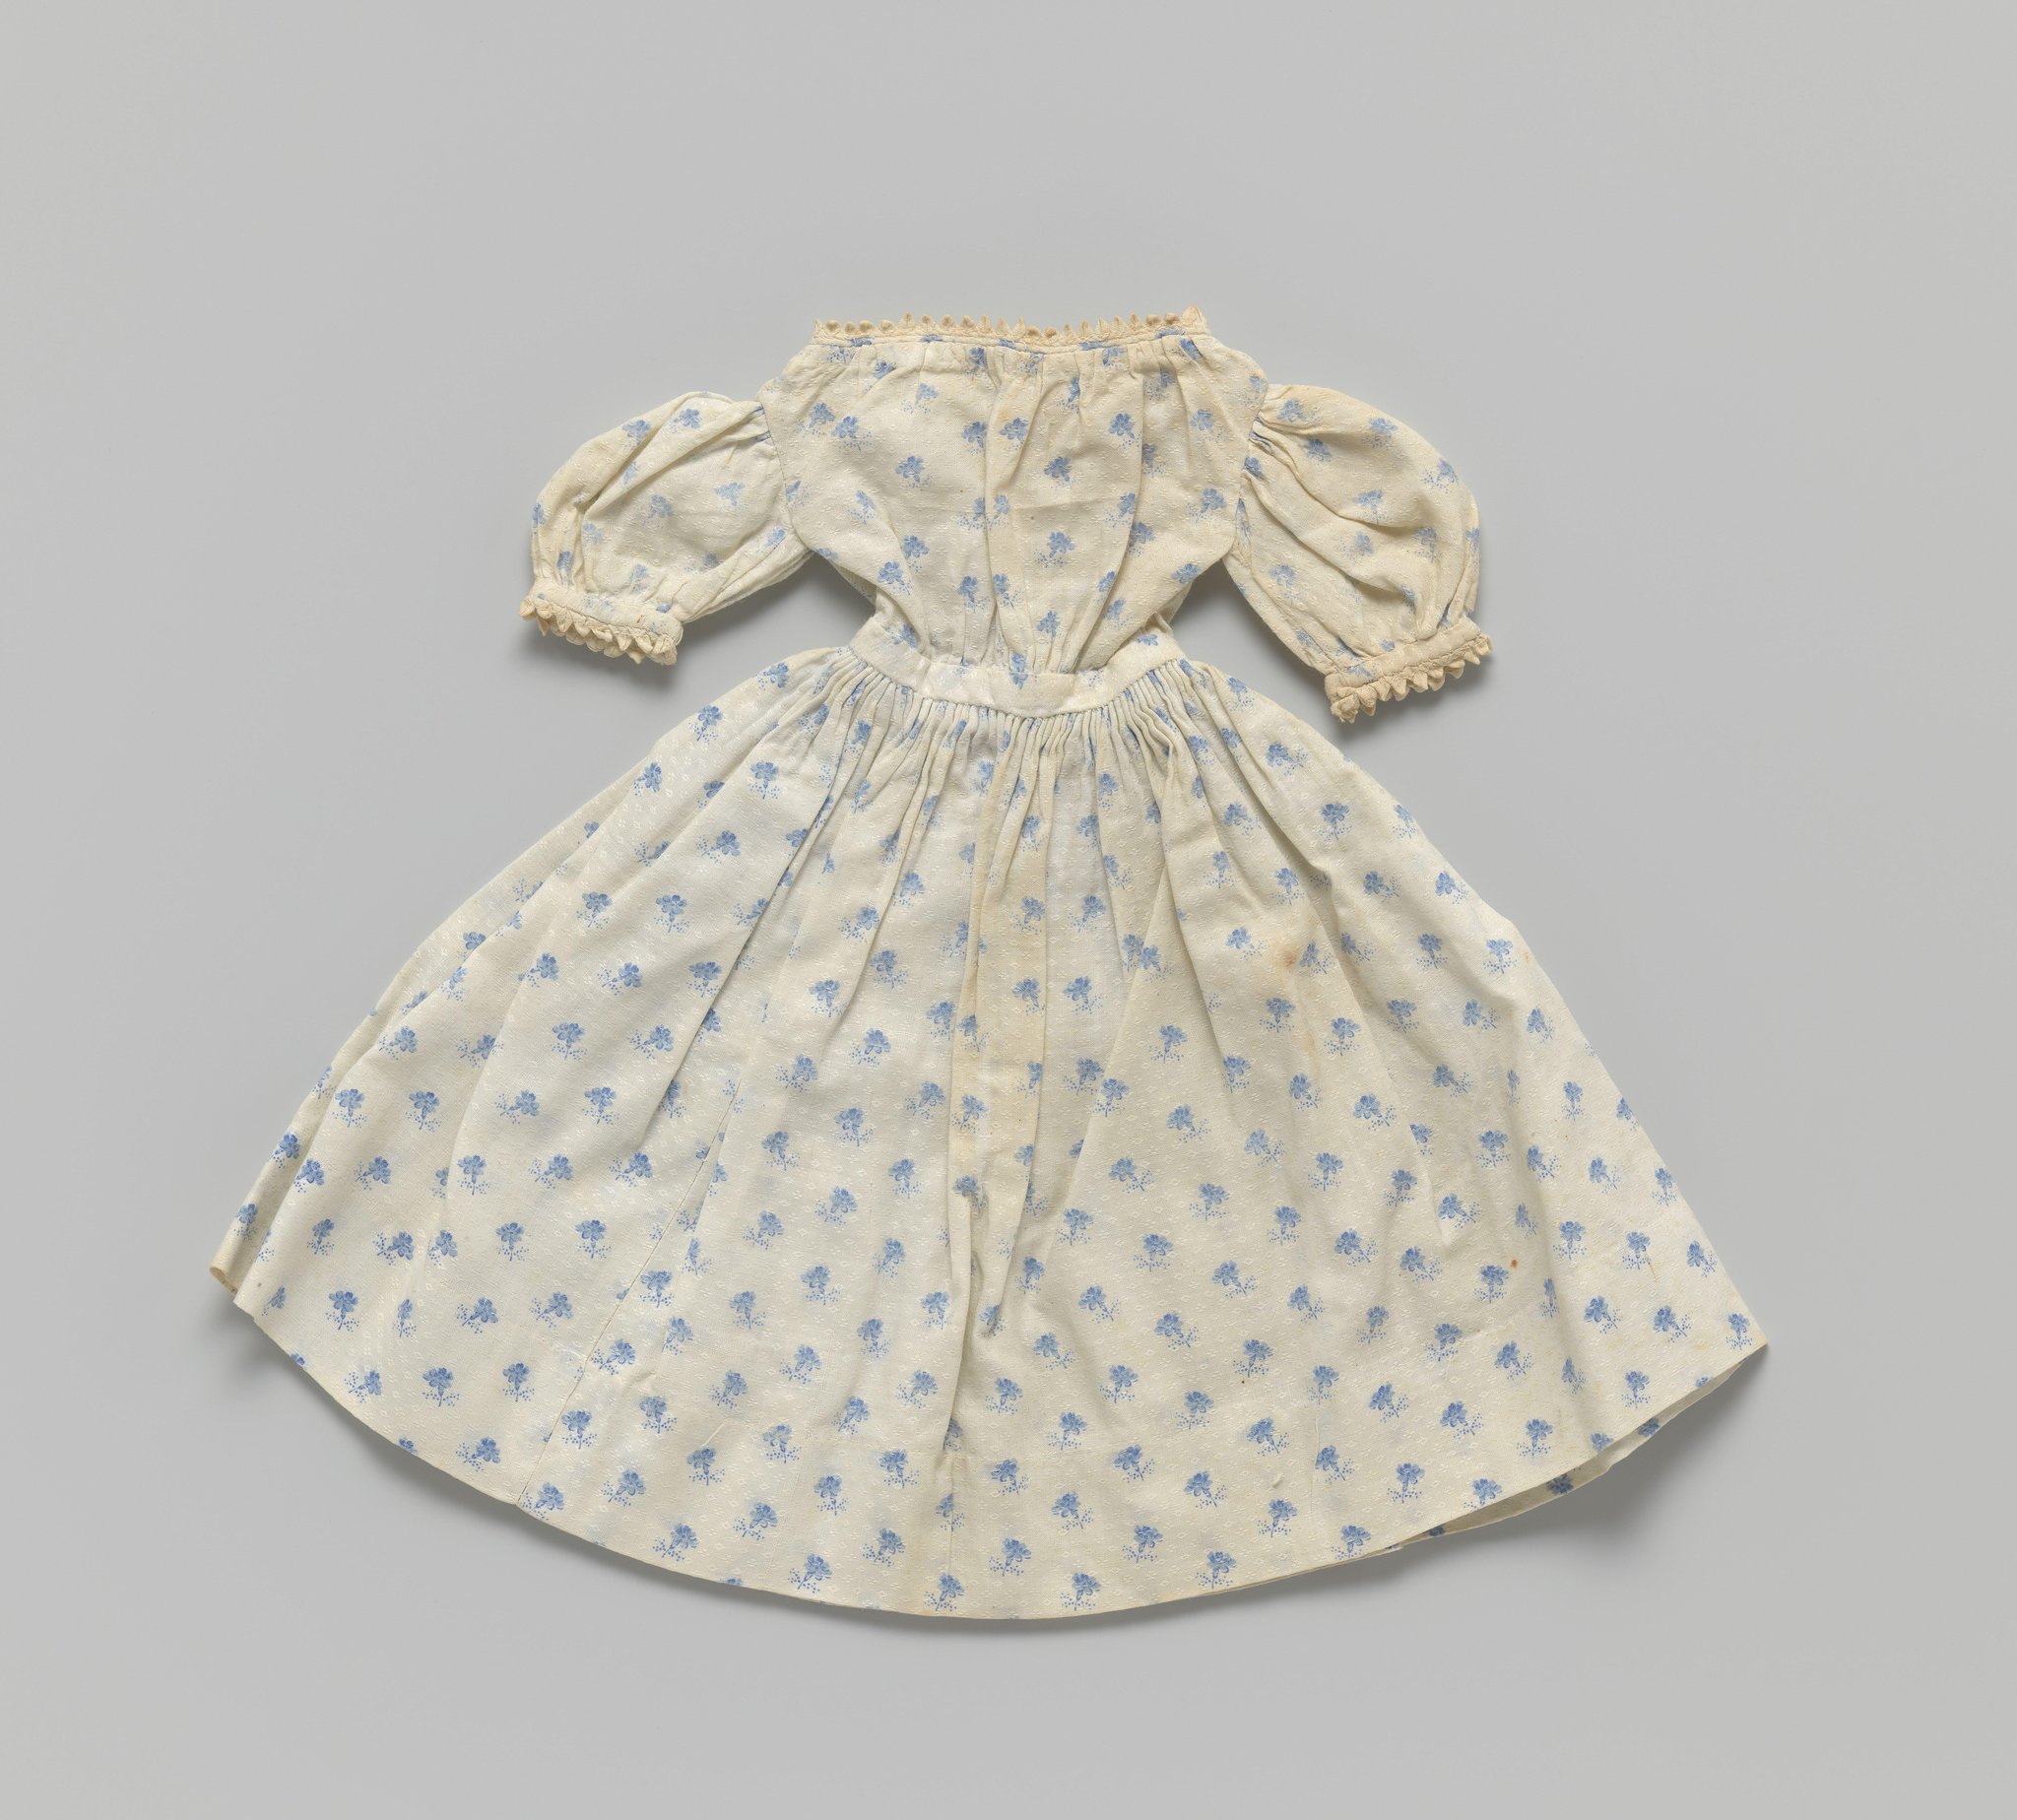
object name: doll's clothing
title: Japon van witte zijde met blauwe bloemetjes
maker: Anonymous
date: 1850-1920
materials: cotton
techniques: printing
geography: europe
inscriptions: number: ‘RBK15445’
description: Japon van witte zijde met ingeweven patroon bedrukt met blauwe bloemetjes.